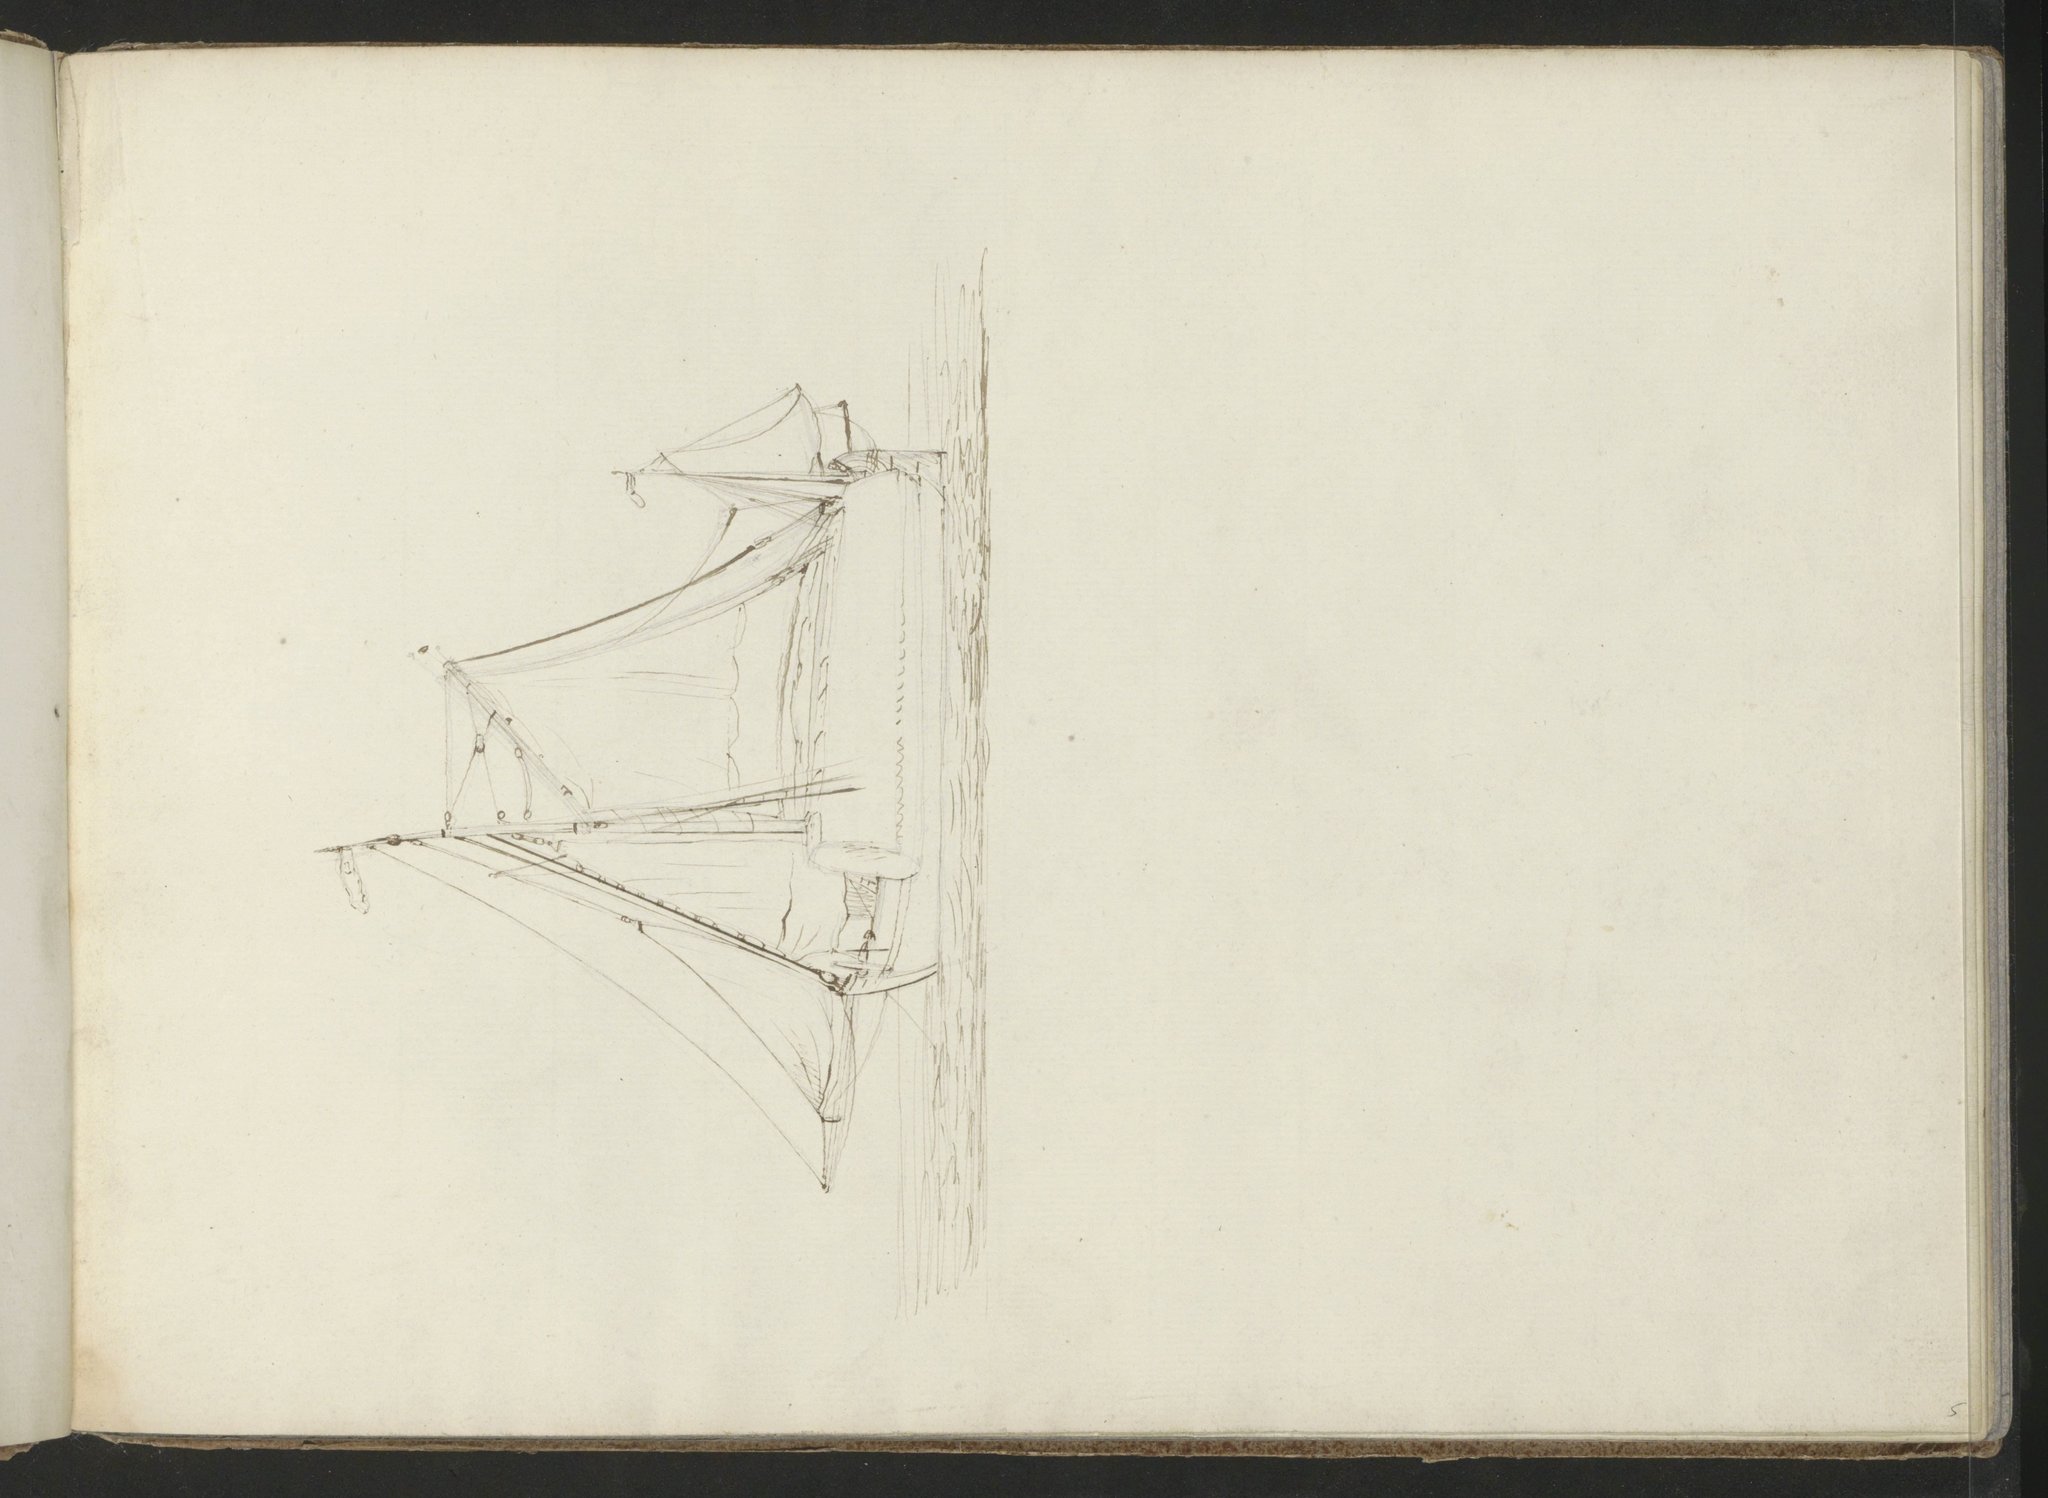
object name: sketchbook leaf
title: Zeilschip op kalm water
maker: s. altmann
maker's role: painter, print maker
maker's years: 1822-1890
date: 1803-1840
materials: ink, paper, pencil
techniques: pen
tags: sailing-ship, sailing-boat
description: Blad 5 recto uit een schetsboek met 24 bladen.